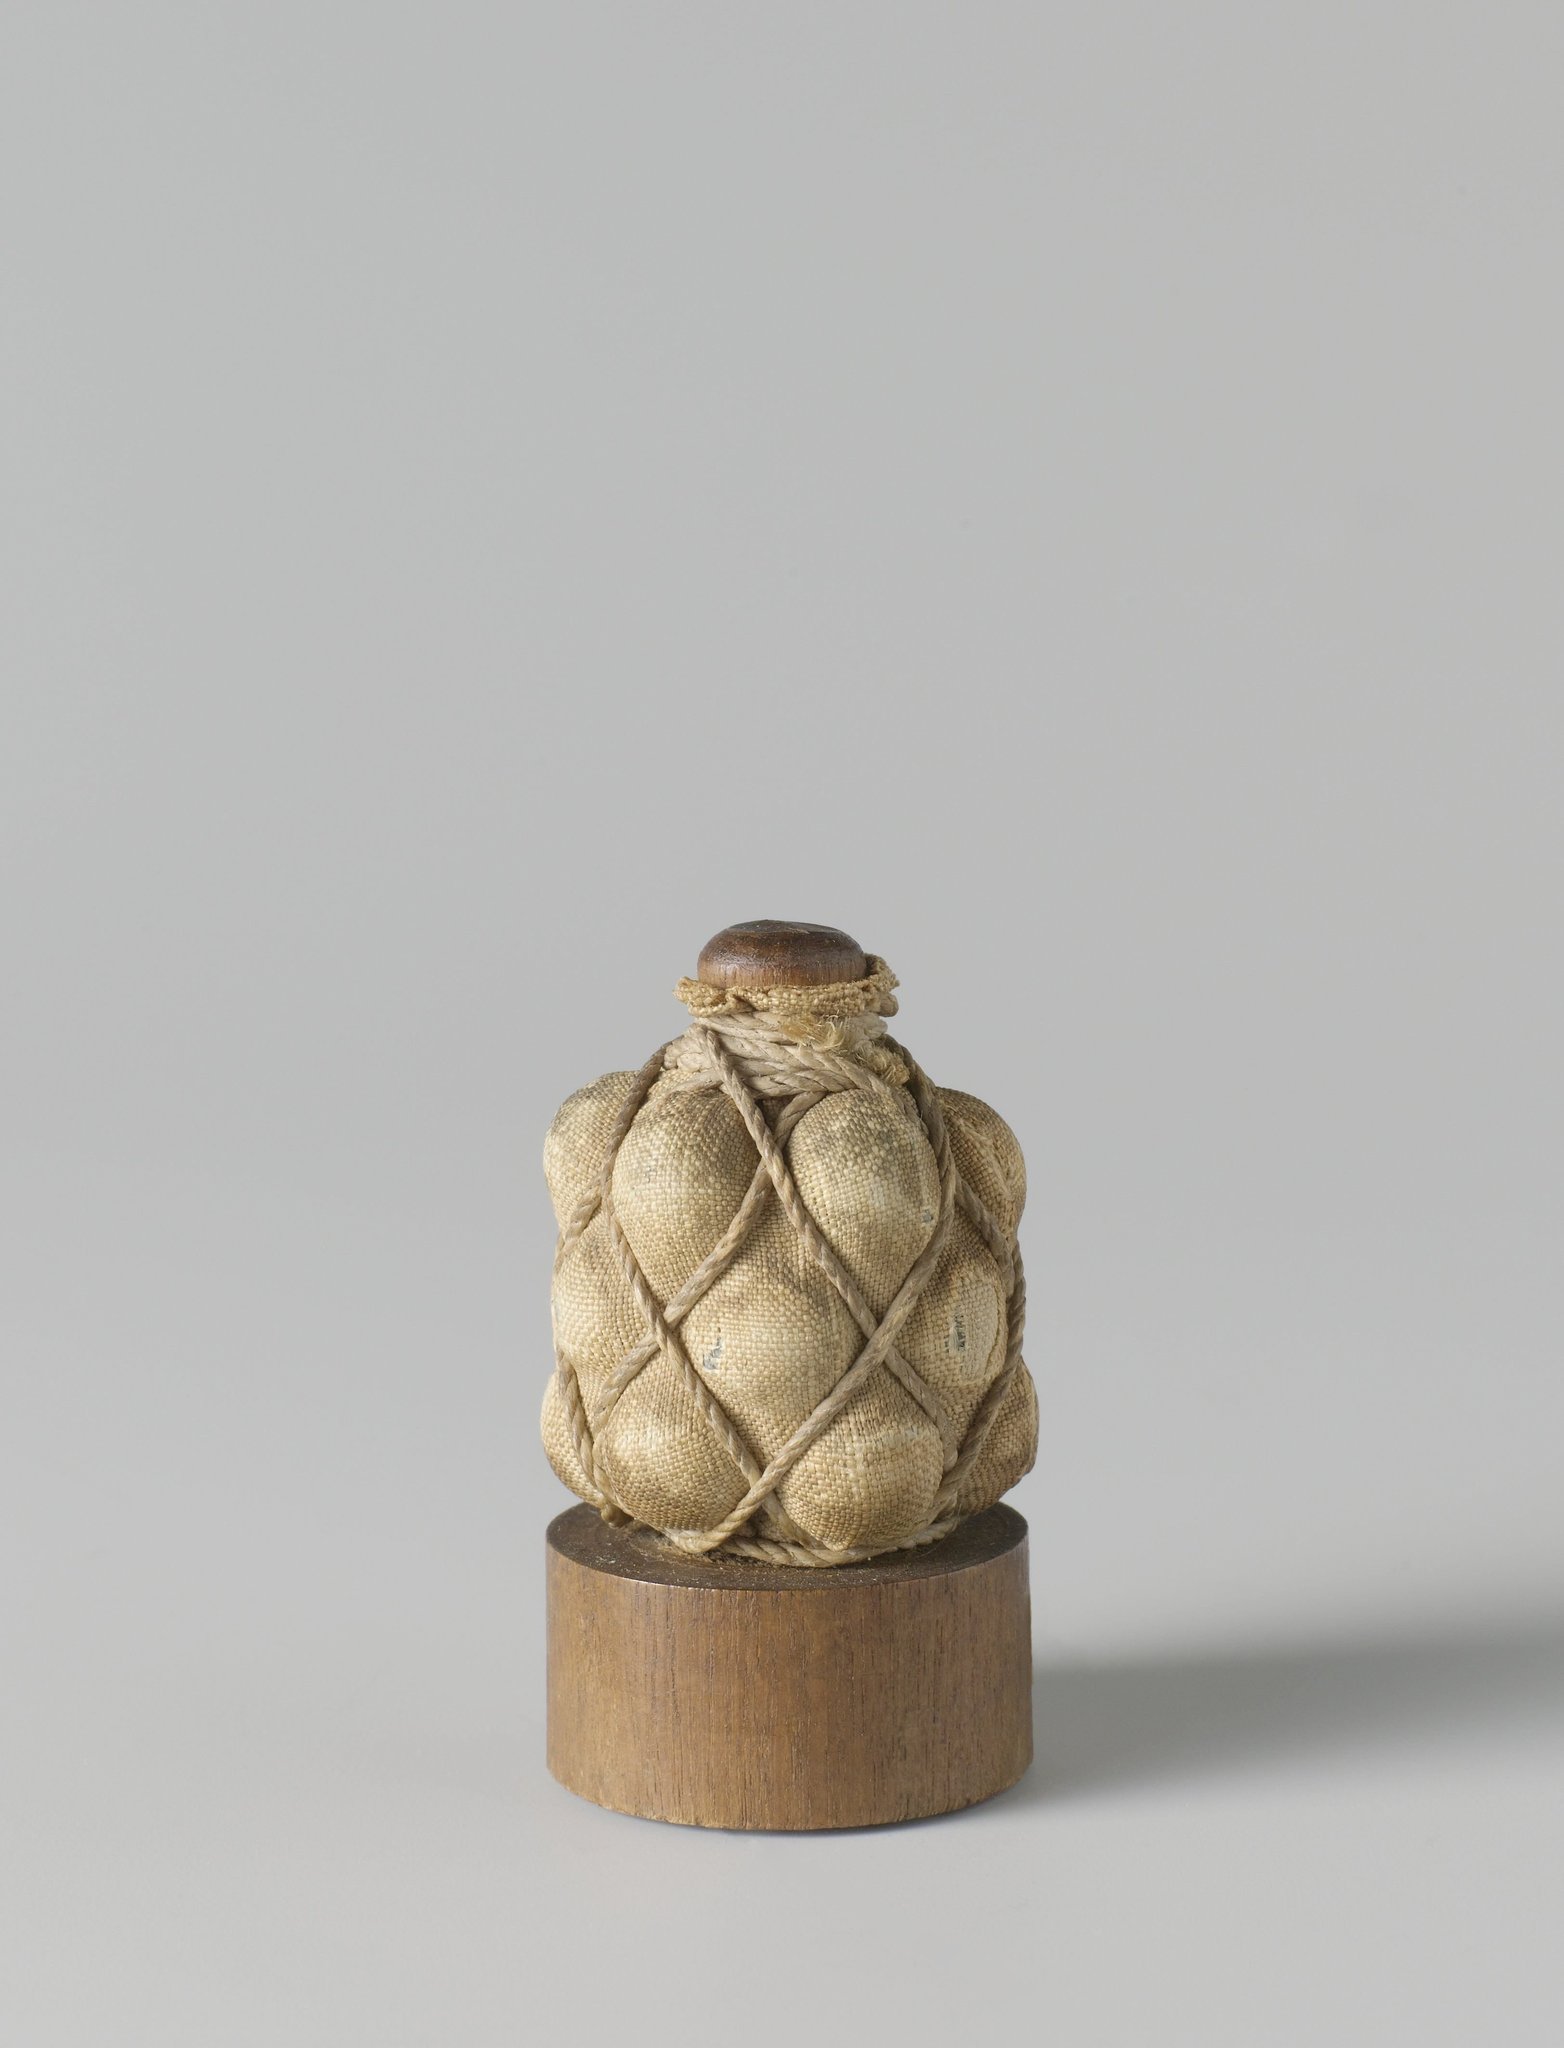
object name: scale model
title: Models of shot bundles (grapeshot)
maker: Anonymous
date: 1750-1800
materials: iron, linen, wood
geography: netherlands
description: A cannon could be loaded with a single cannonball or bundles of smaller projectiles, such as this ‘grapeshot’. Grapeshot consisted of a canvas bag filled with iron balls or metal slugs, tied together so that it resembled a bunch of grapes. It was used to hit living targets – horses and soldiers – at close range. The Dutch word for machine gun (mitrailleur) comes from the French term for grapeshot (boîte à mitraille).